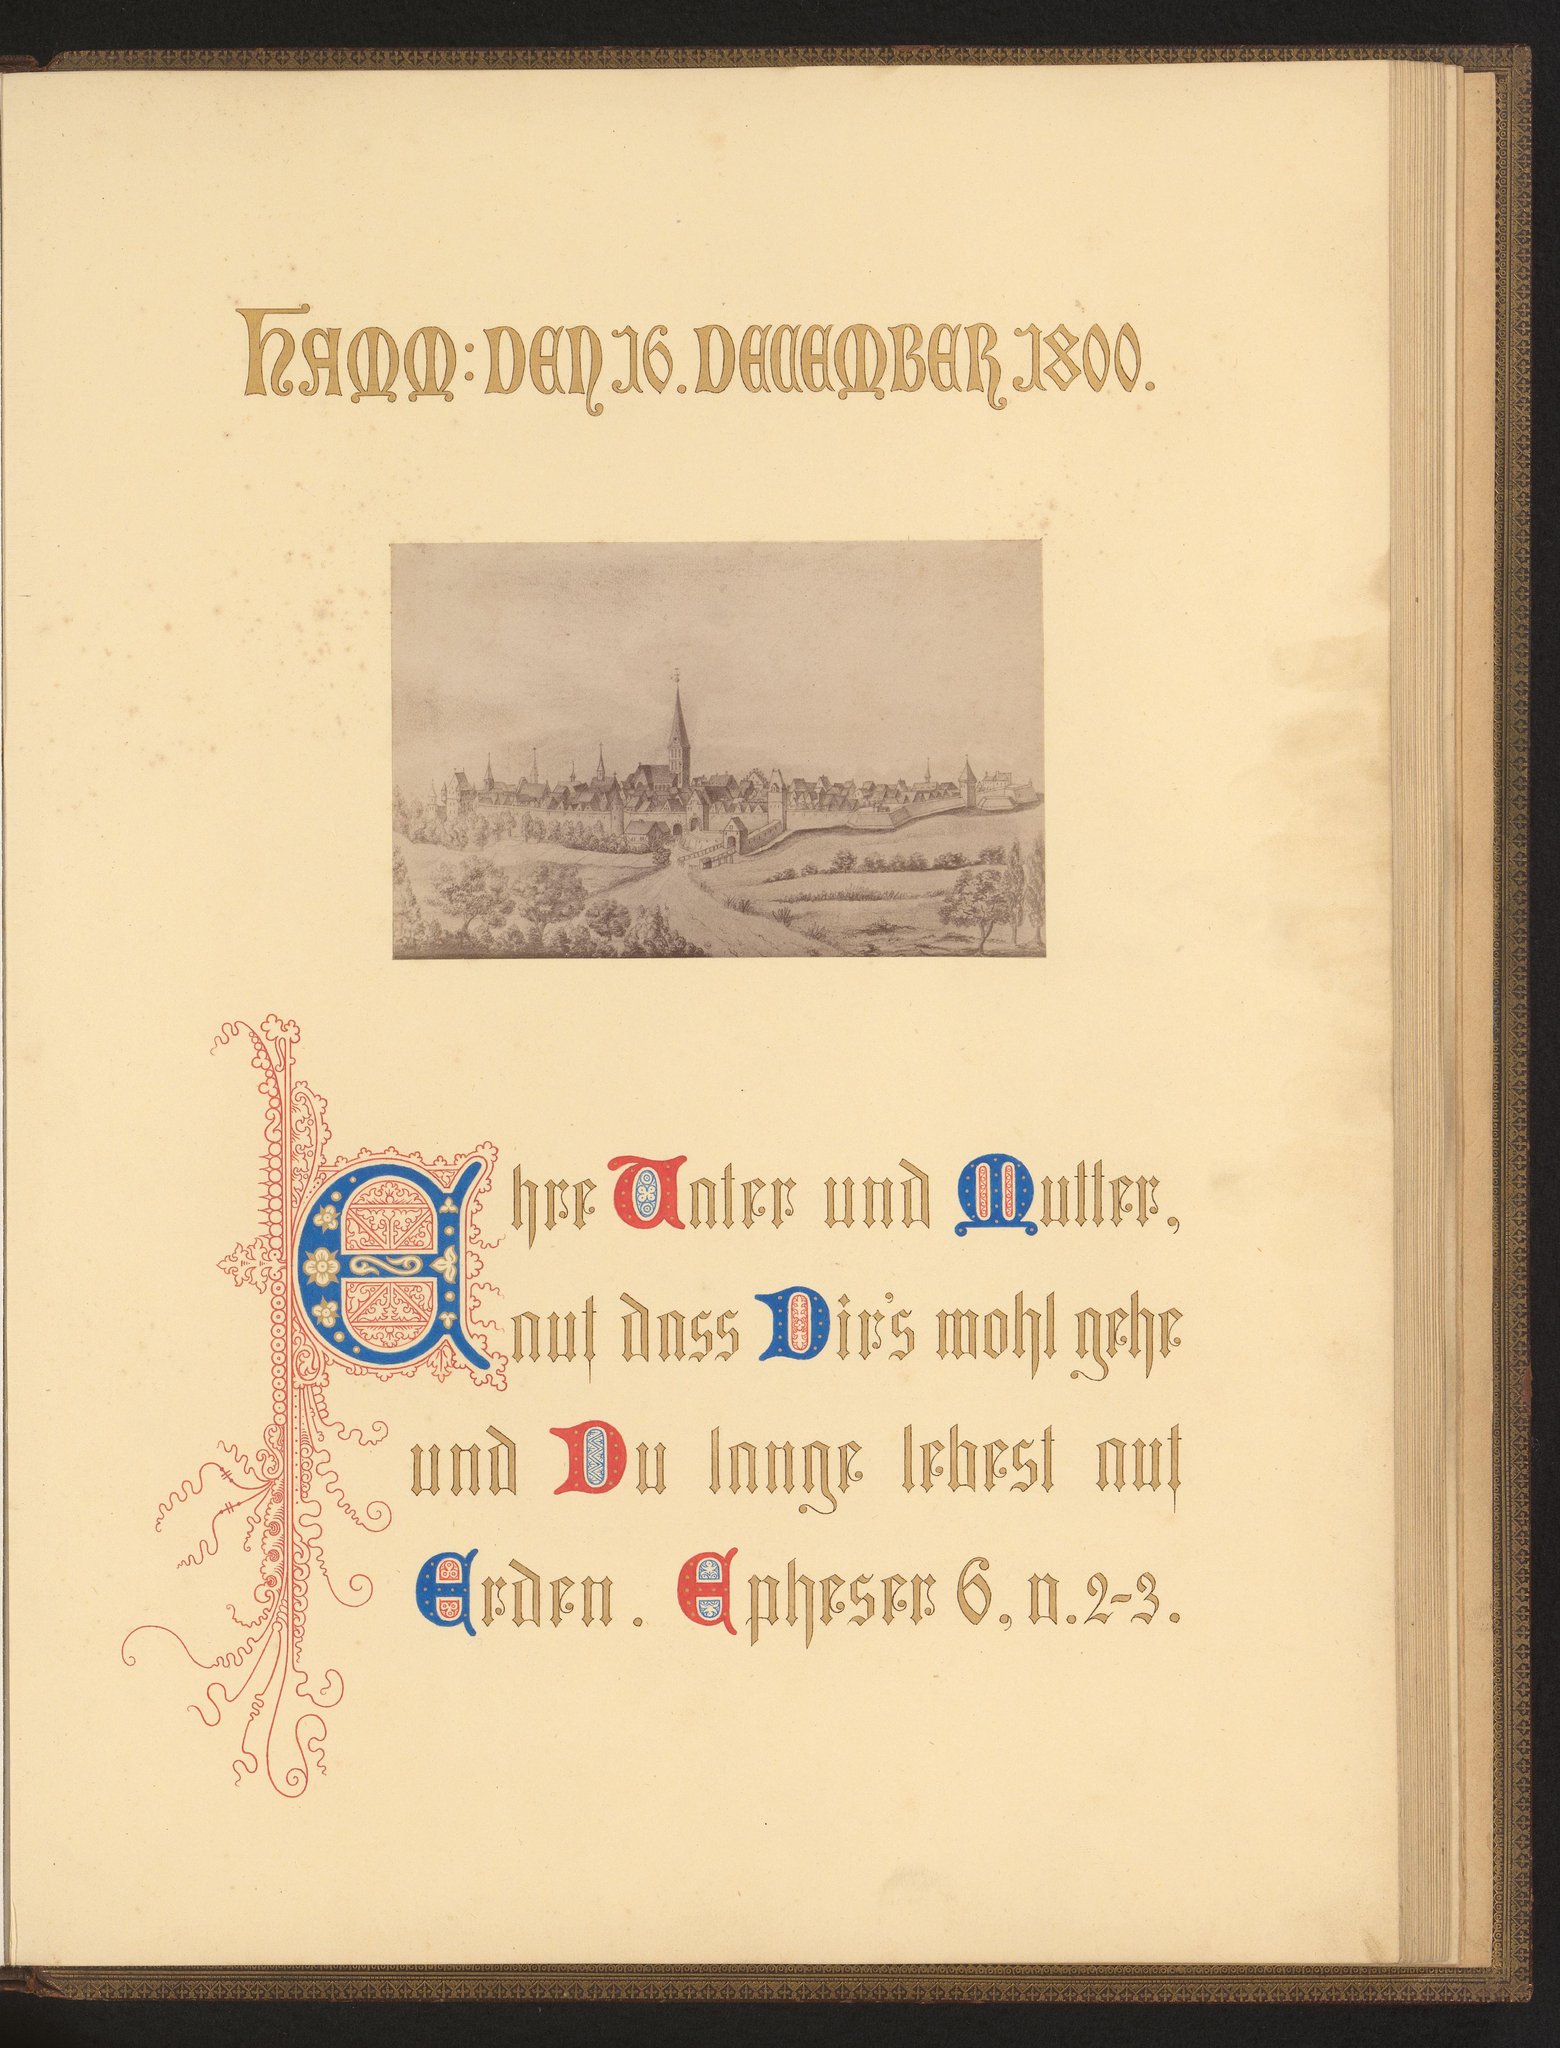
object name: album leaf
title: Hamm: den 16. December 1800.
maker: Anonymous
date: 1873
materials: paper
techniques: albumen print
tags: city-view in general; 'veduta'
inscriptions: inscription: ‘Ehre Vater und Mutter,/ auf dass Dir's wohl gehe/ und Du lange lebest auf/ Erden. Epheser 6, o. 2-3.’